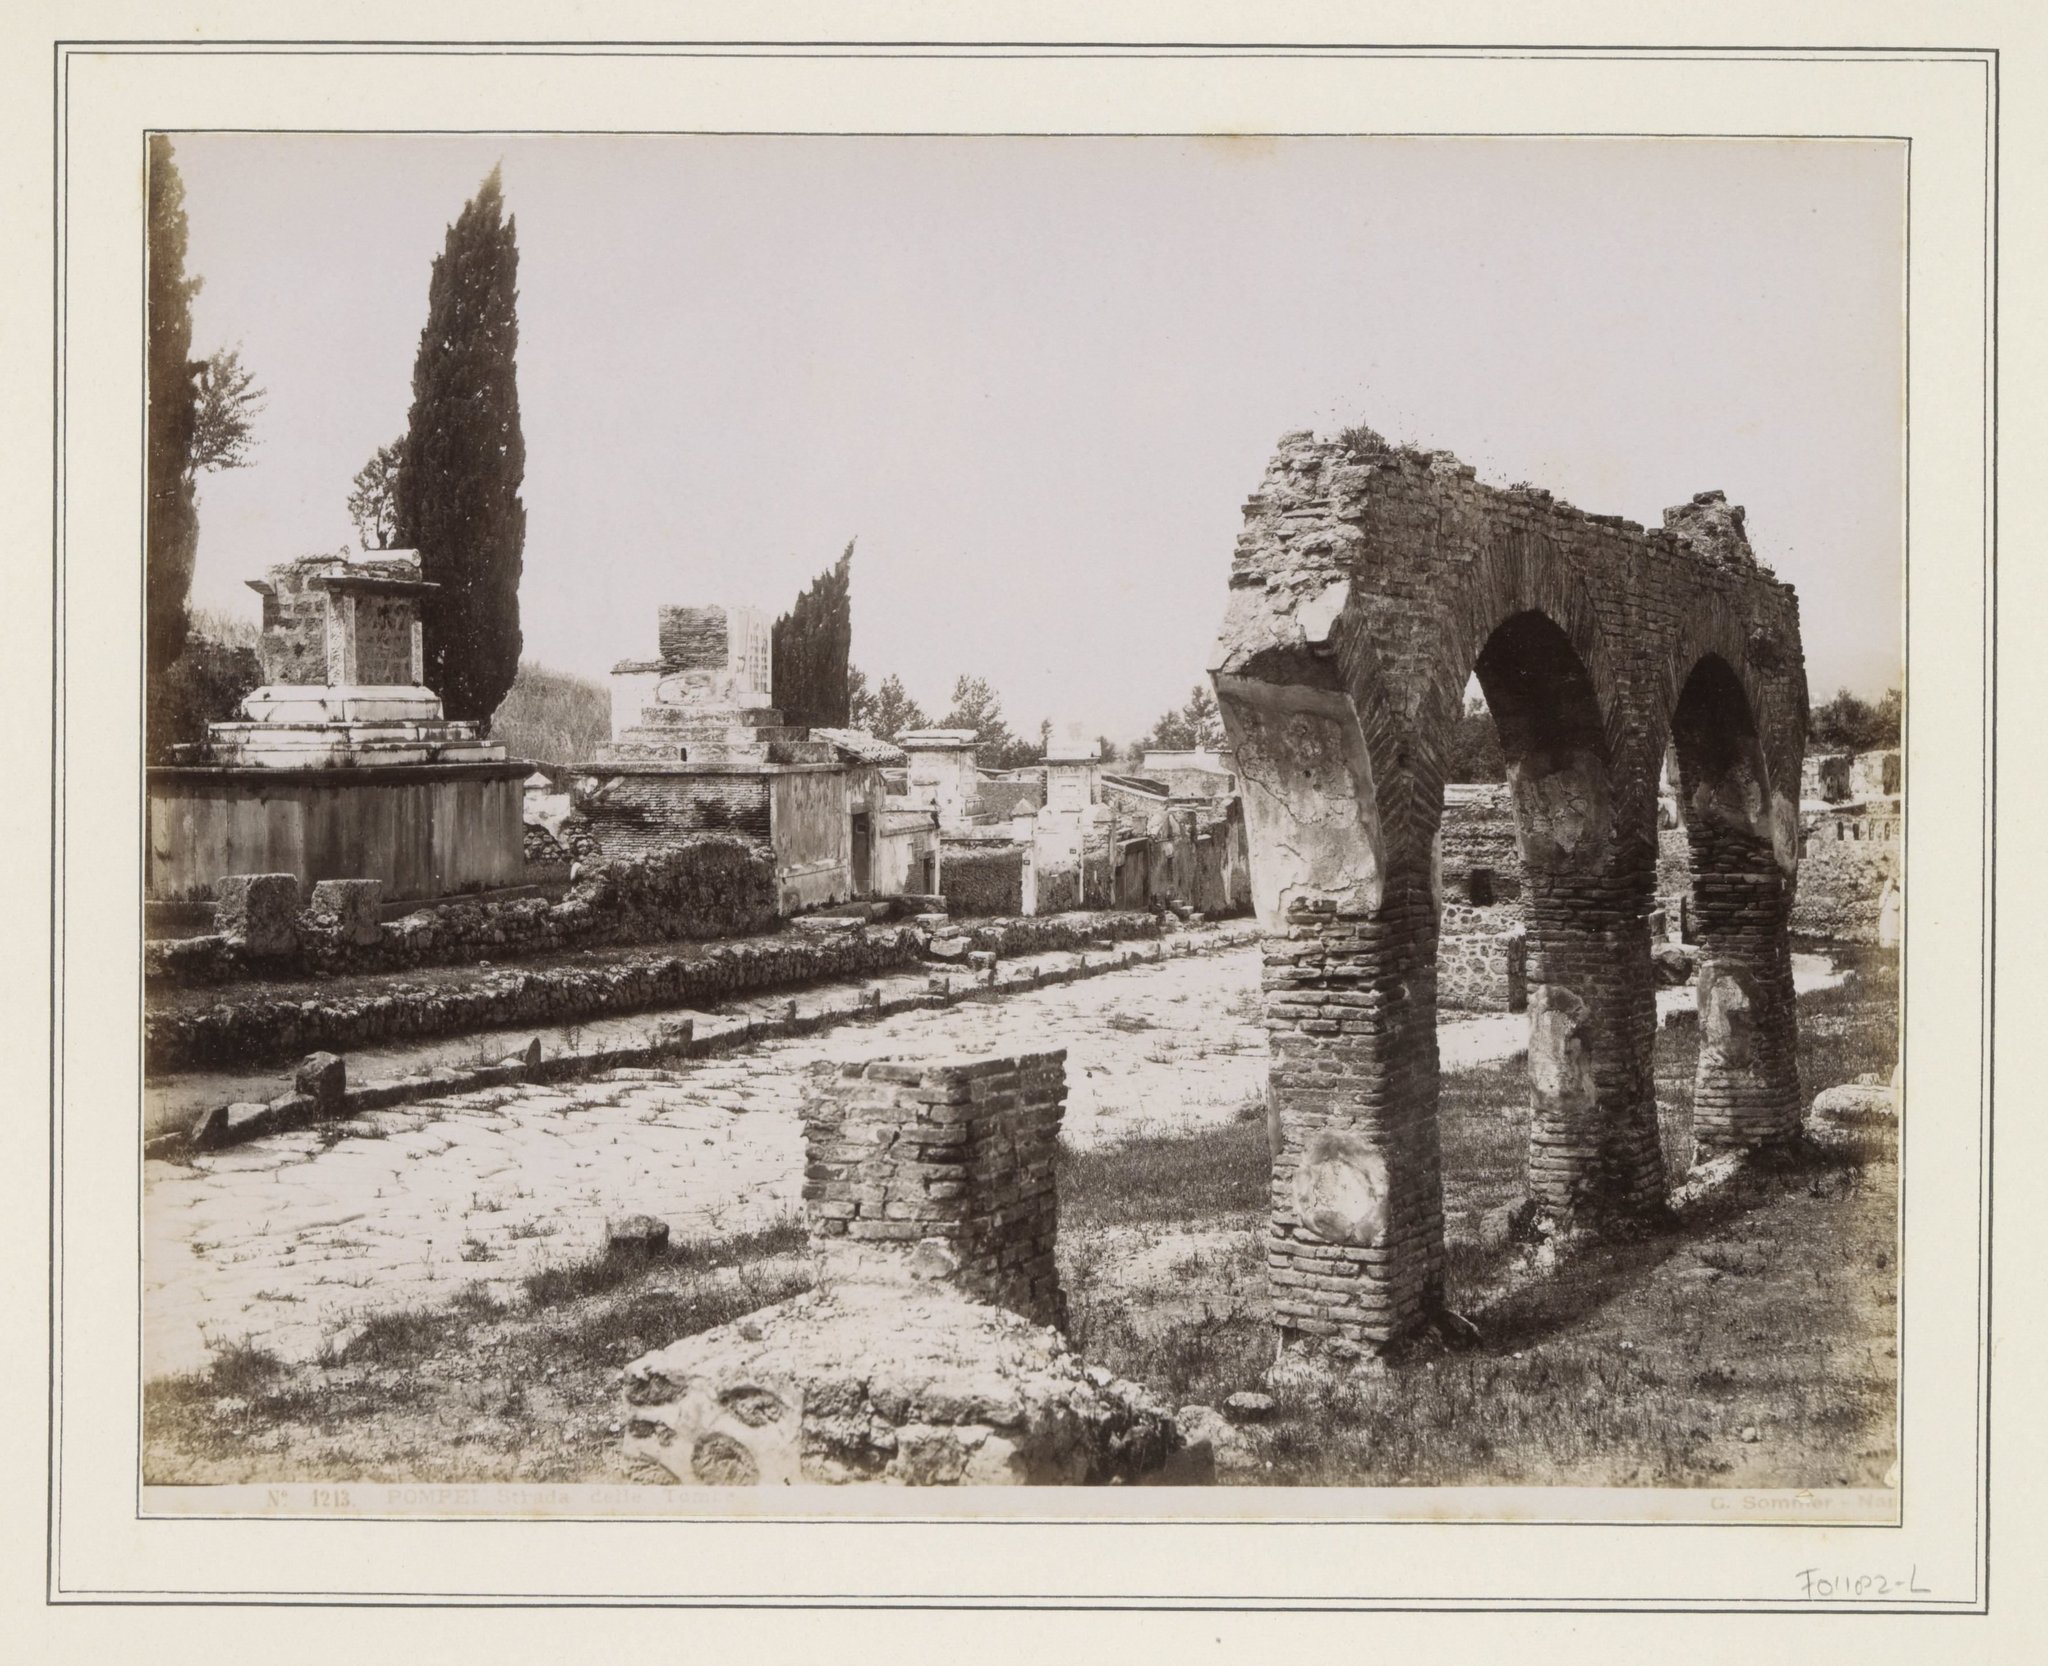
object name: photograph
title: Restanten van Strada delle Tombe in Pompeï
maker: giorgio sommer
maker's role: fotograaf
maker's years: 1834-1914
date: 1860-1890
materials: paper, photographic support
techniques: albumen print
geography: pompeii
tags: excavation ~ archaeology, pompeii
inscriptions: negative number: ‘1213’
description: Onderdeel van Reisalbum met foto's van bezienswaardigheden in Italië en aan de Franse Rivièra (deel II).